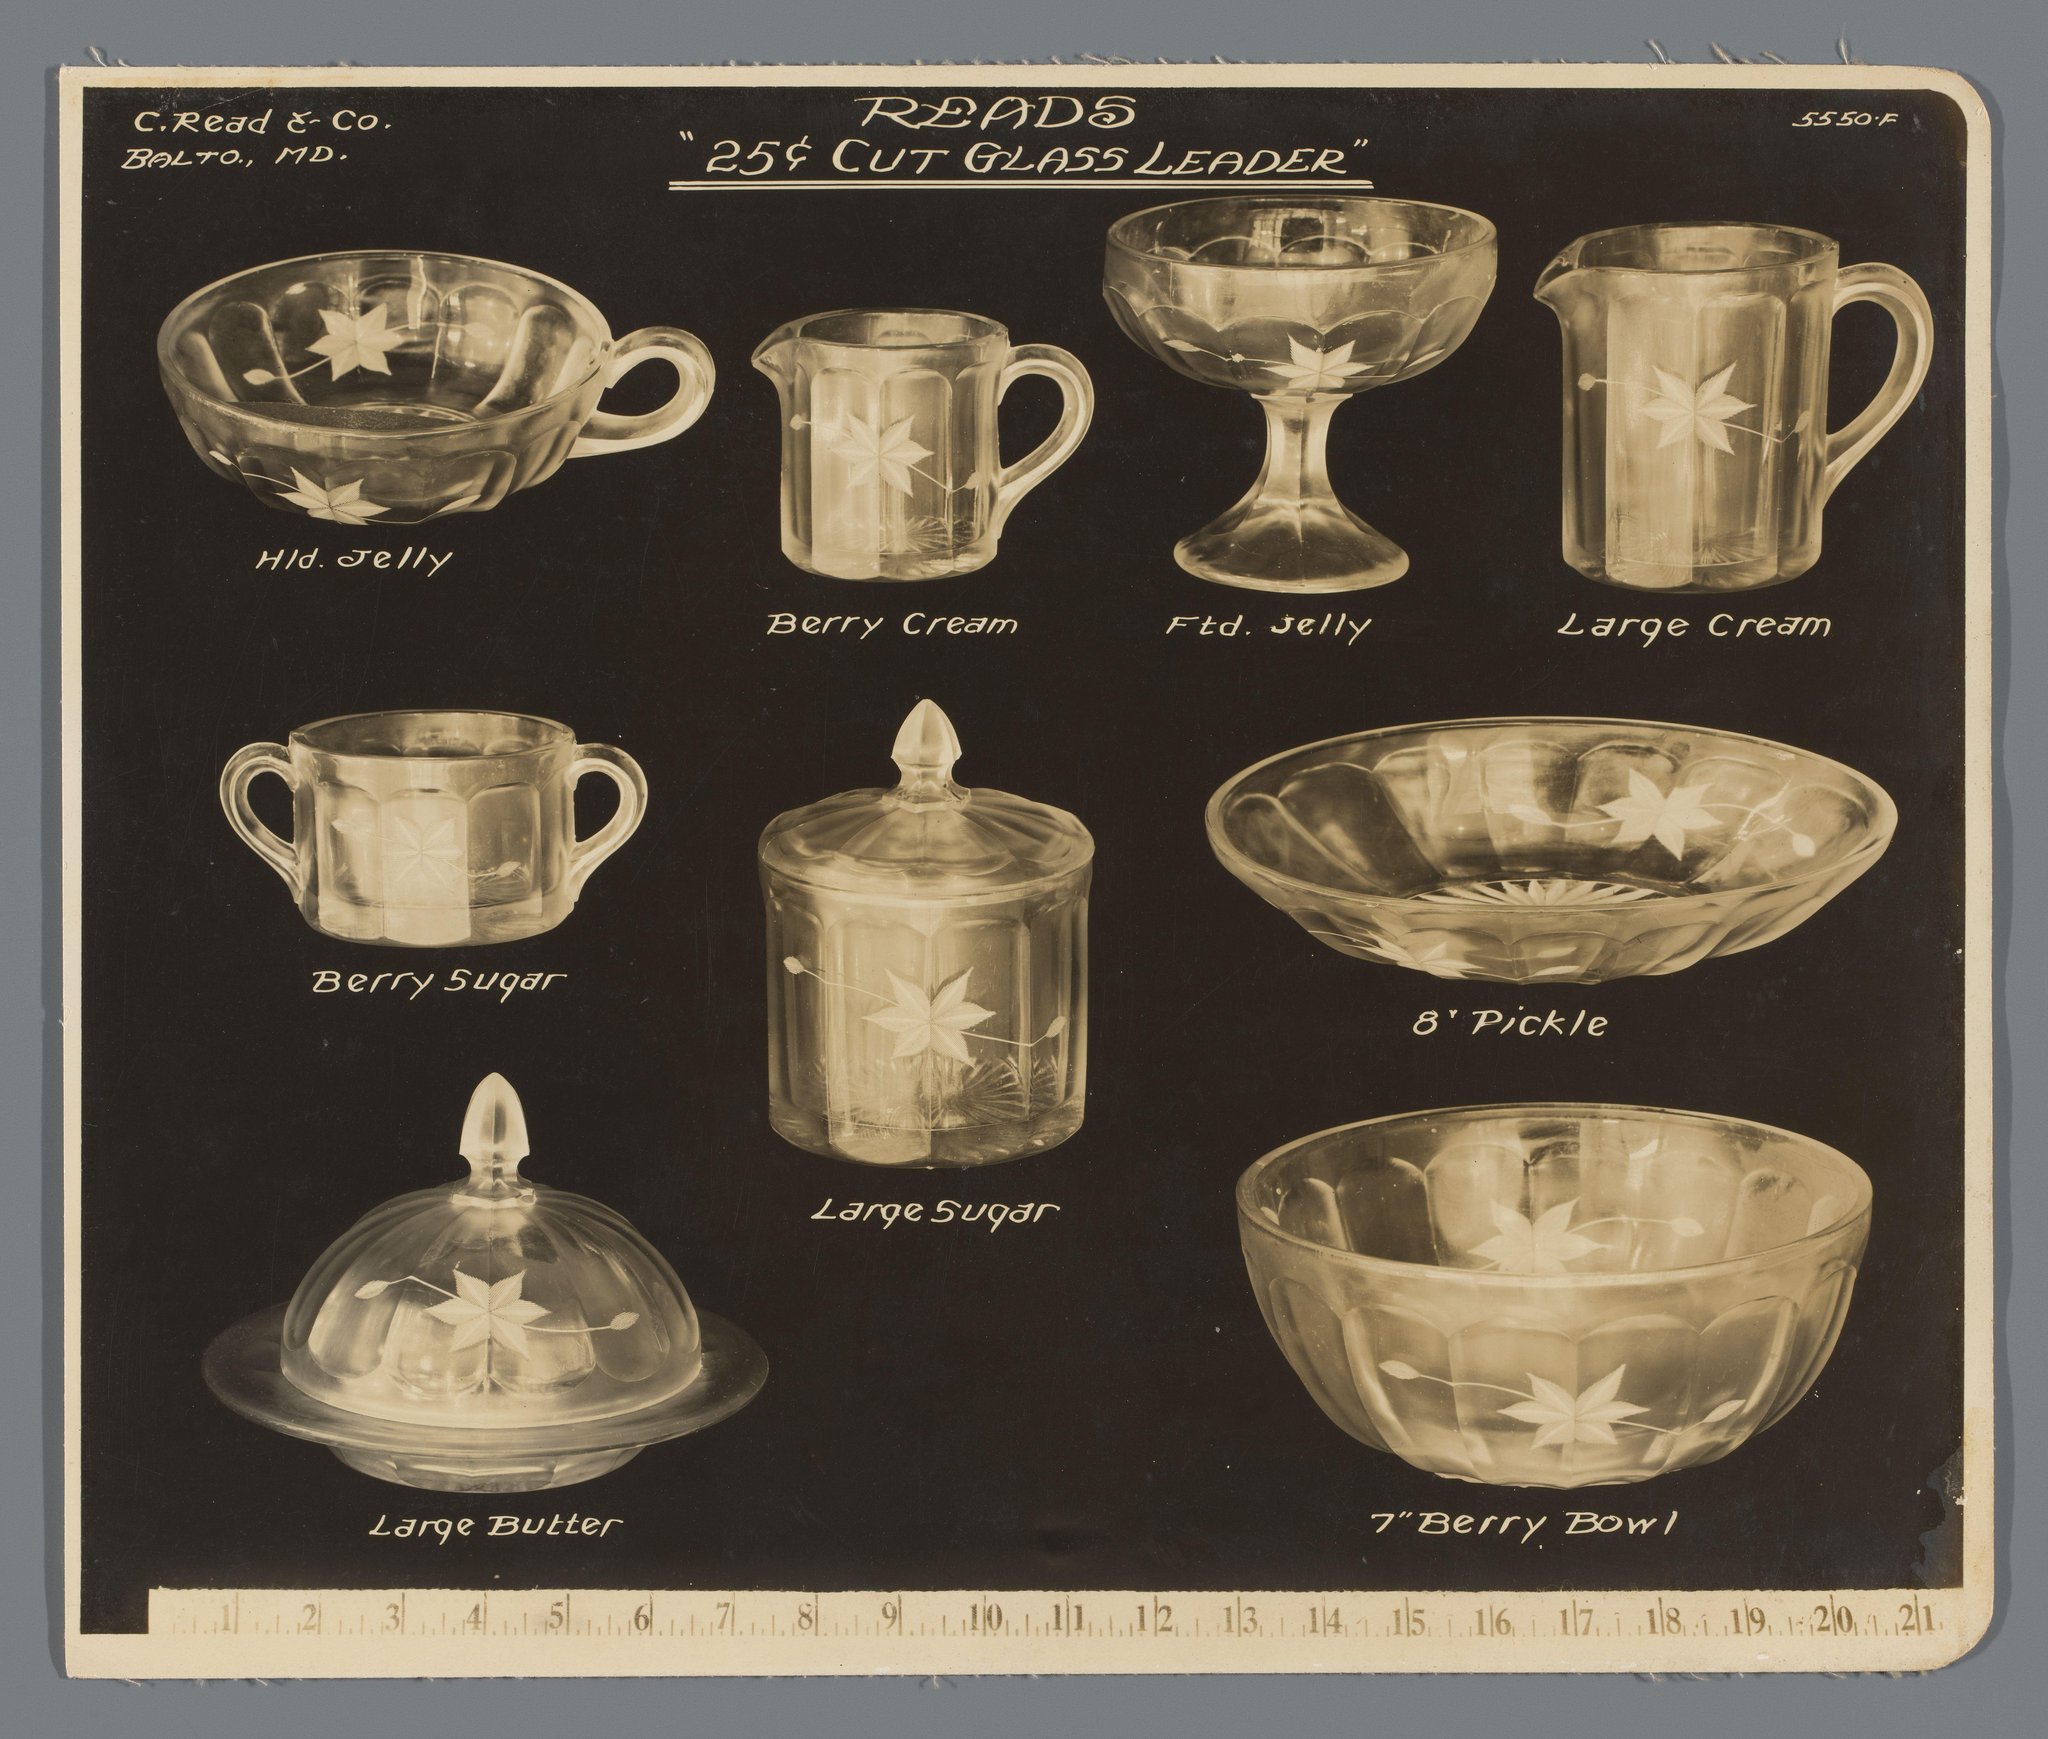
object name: photograph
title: Reclamefoto met serviezen en keukengerei van de firma C. Read & Co., Baltimore, Maryland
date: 1920-1930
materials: paper, textile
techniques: photography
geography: united states